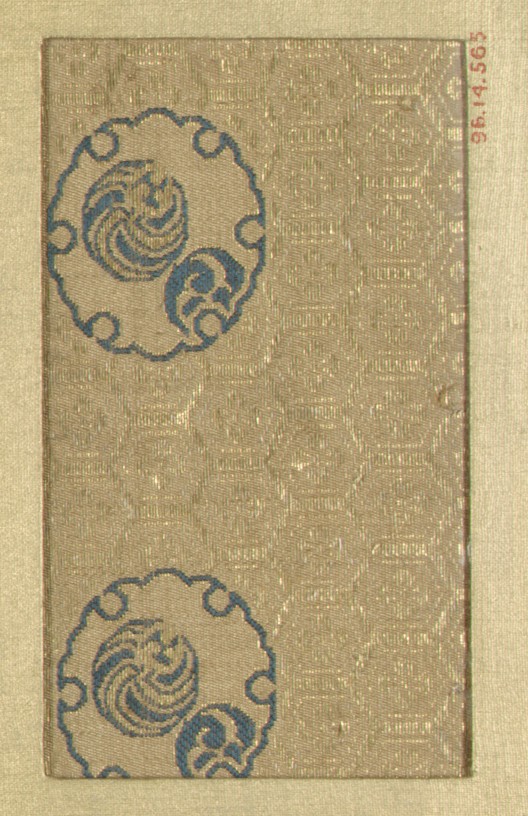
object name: piece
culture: japanese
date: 1701-1900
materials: silk